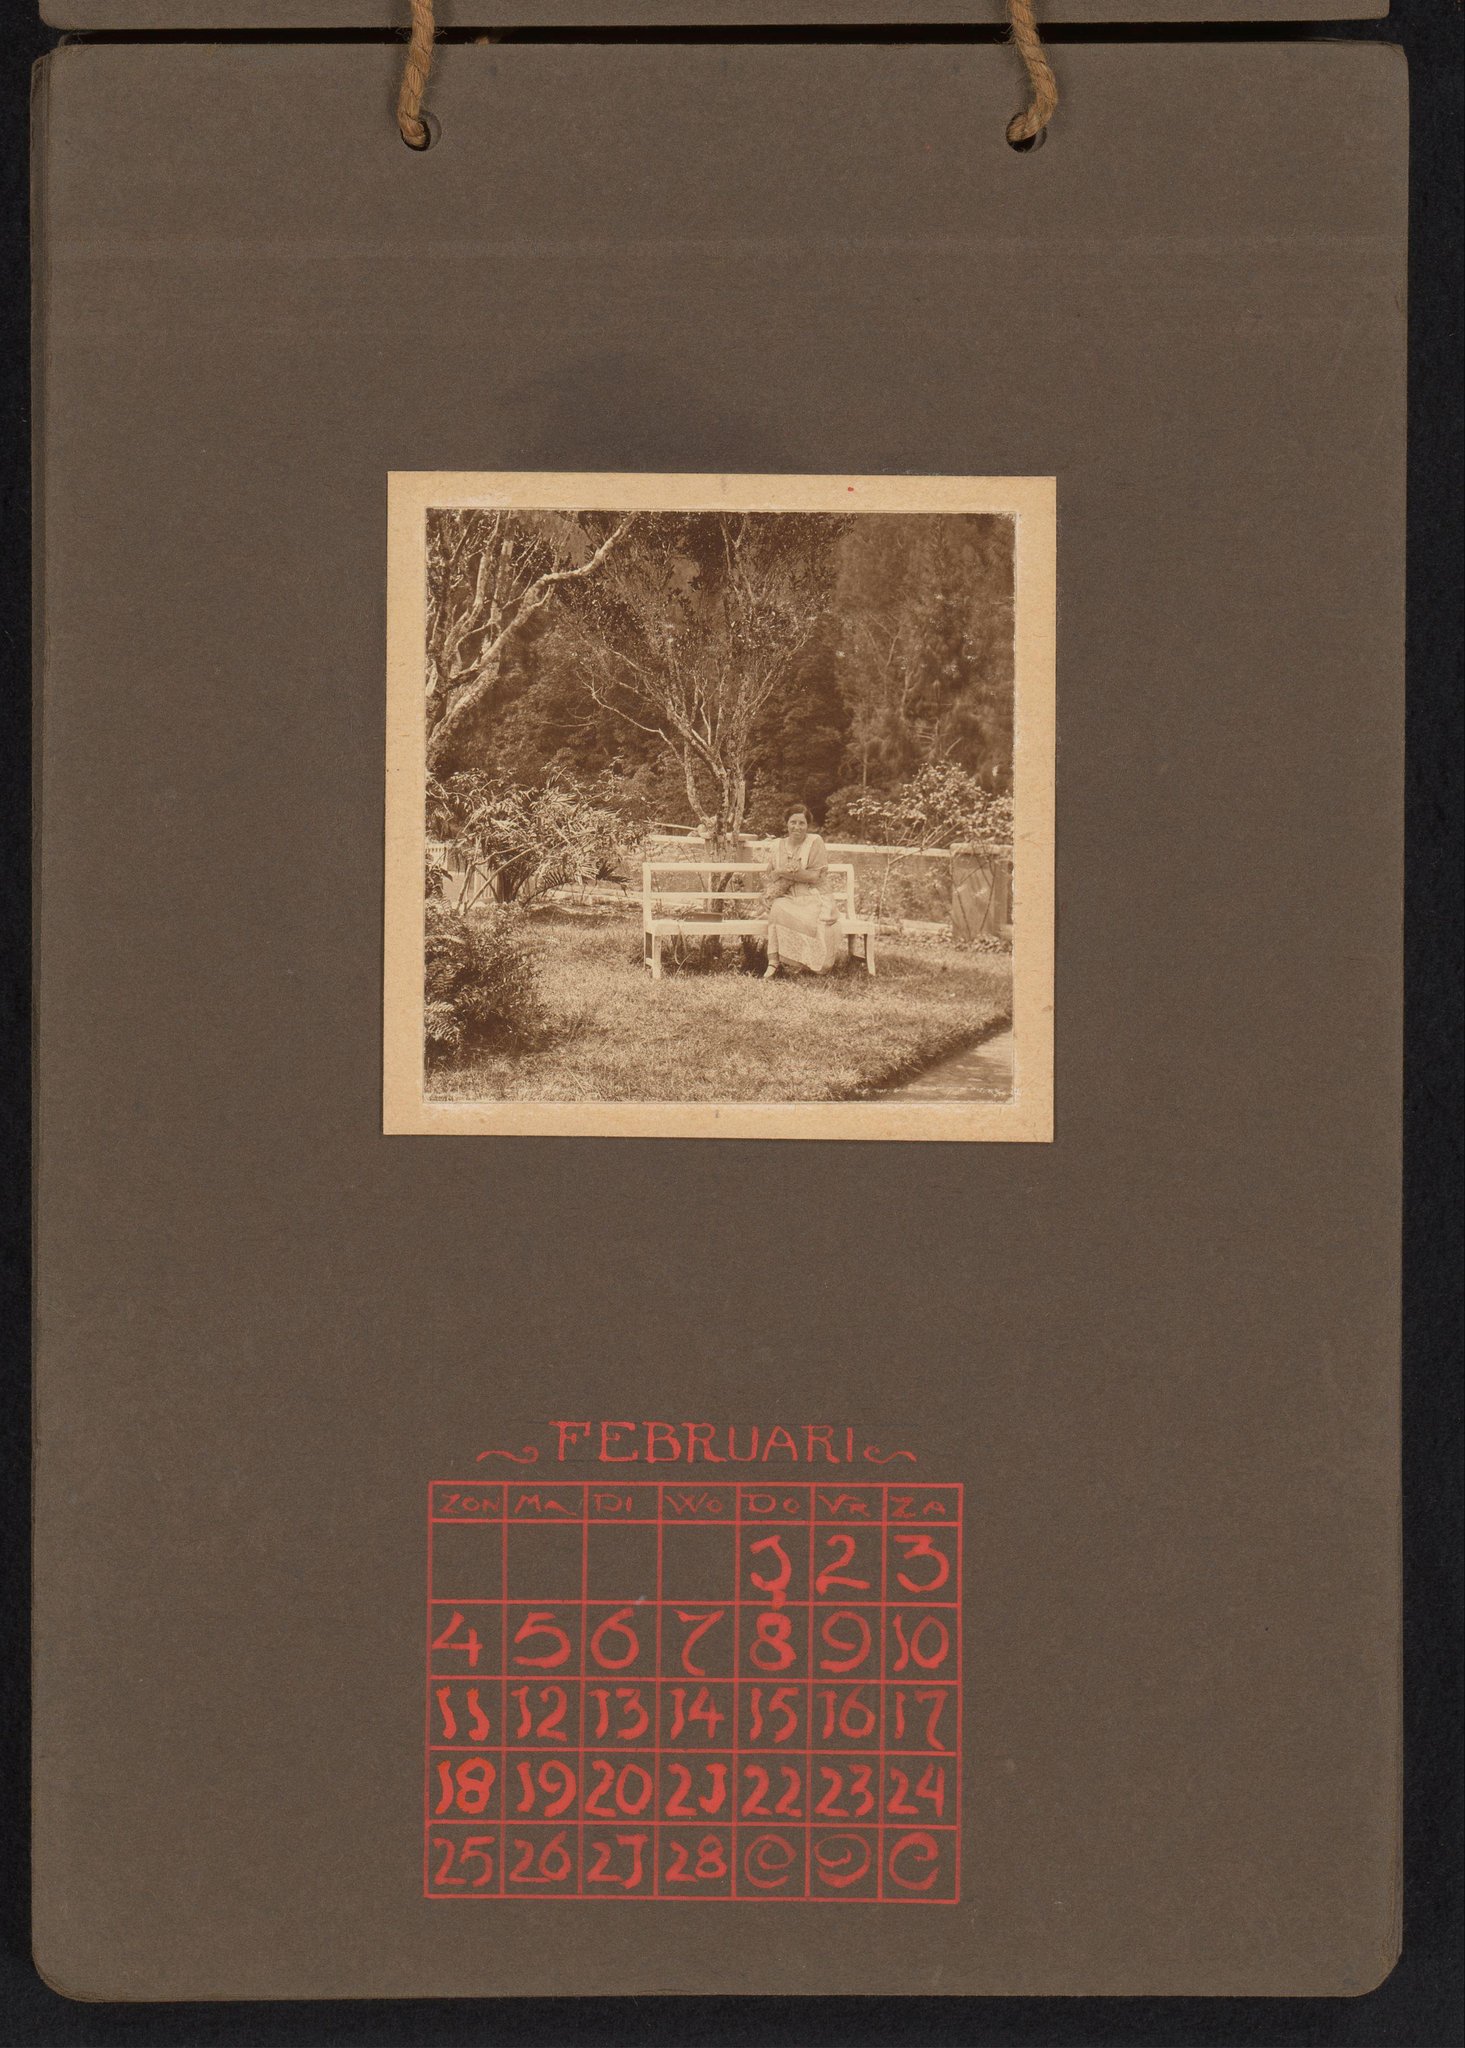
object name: album leaf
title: Vrouw met een kat op de arm op een wit bankje in een tuin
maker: Anonymous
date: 1880-1923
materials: cardboard, paper, photographic support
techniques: collodion silver print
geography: indonesia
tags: bench, adult woman, cat, garden, indonesia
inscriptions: annotation: ‘FEBRUARI/ (...)’